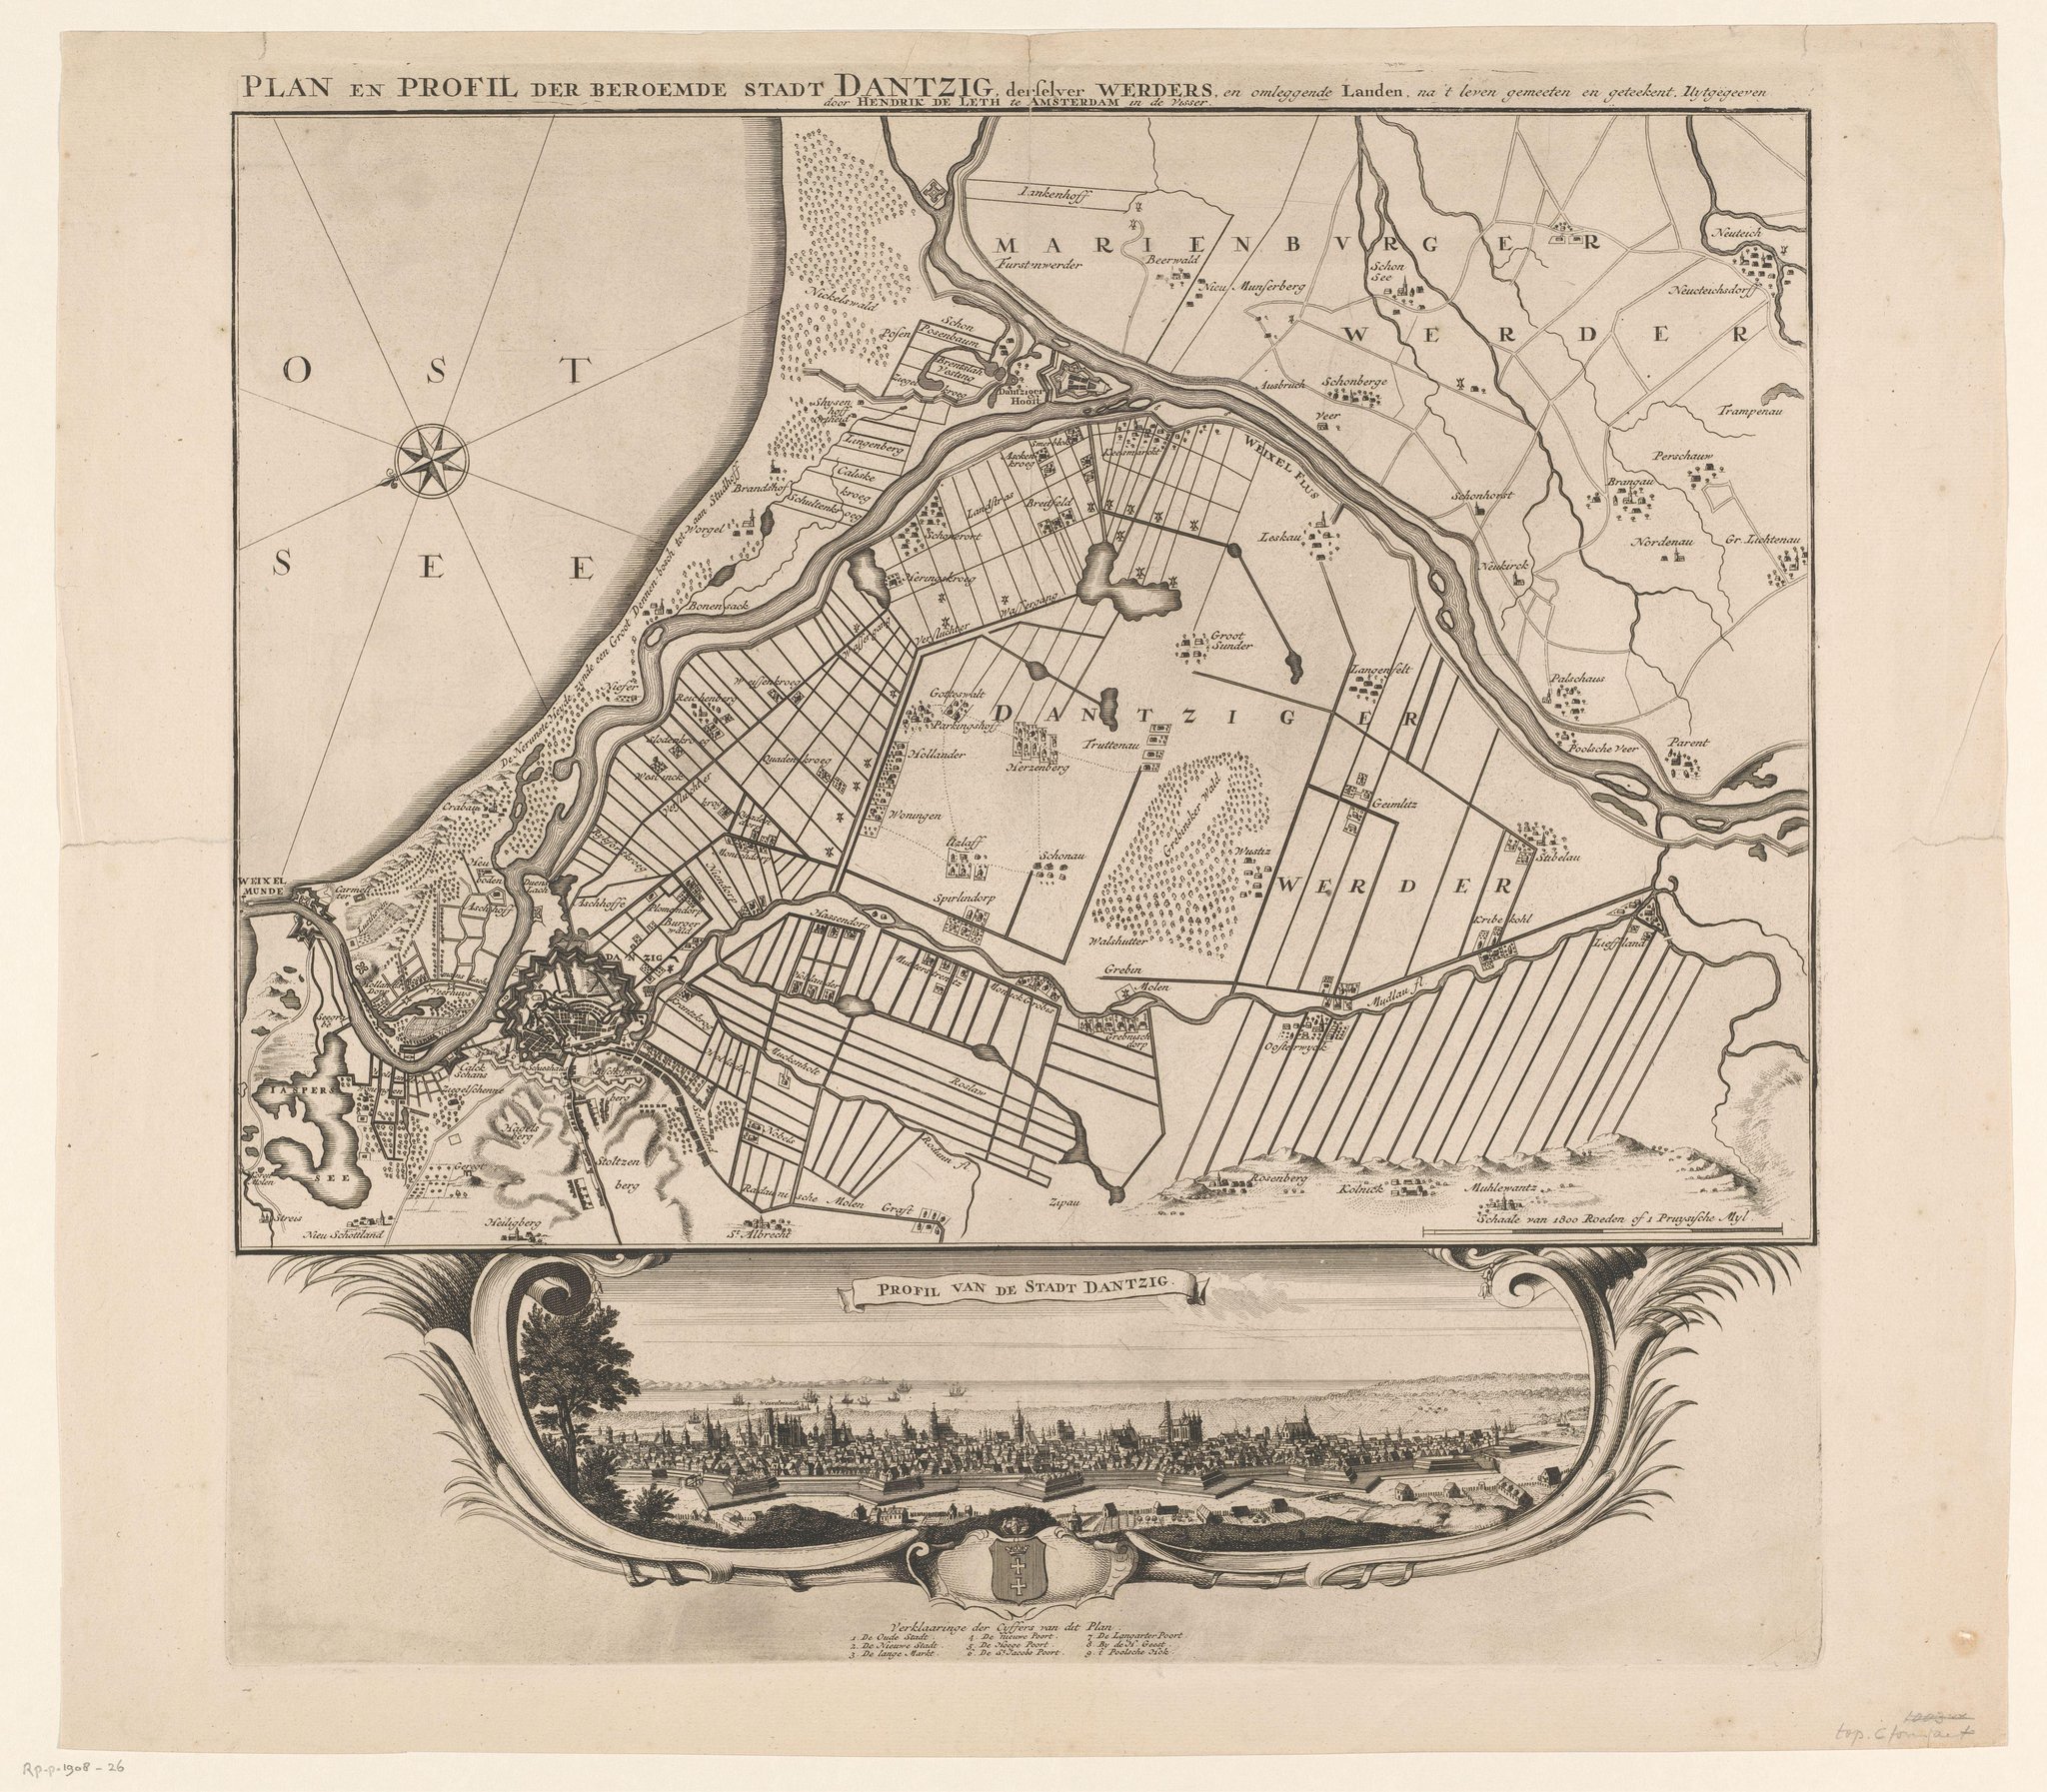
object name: print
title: Plattegrond van de omgeving van Gdansk en een gezicht op Gdansk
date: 1726-1766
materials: paper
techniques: engraving, etching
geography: amsterdam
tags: coat of arms (as symbol of the state, etc.) (+ city; municipal), maps of separate countries or regions, maps of cities, prospect of city, town panorama, silhouette of city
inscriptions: collector's mark: Lugt 2228